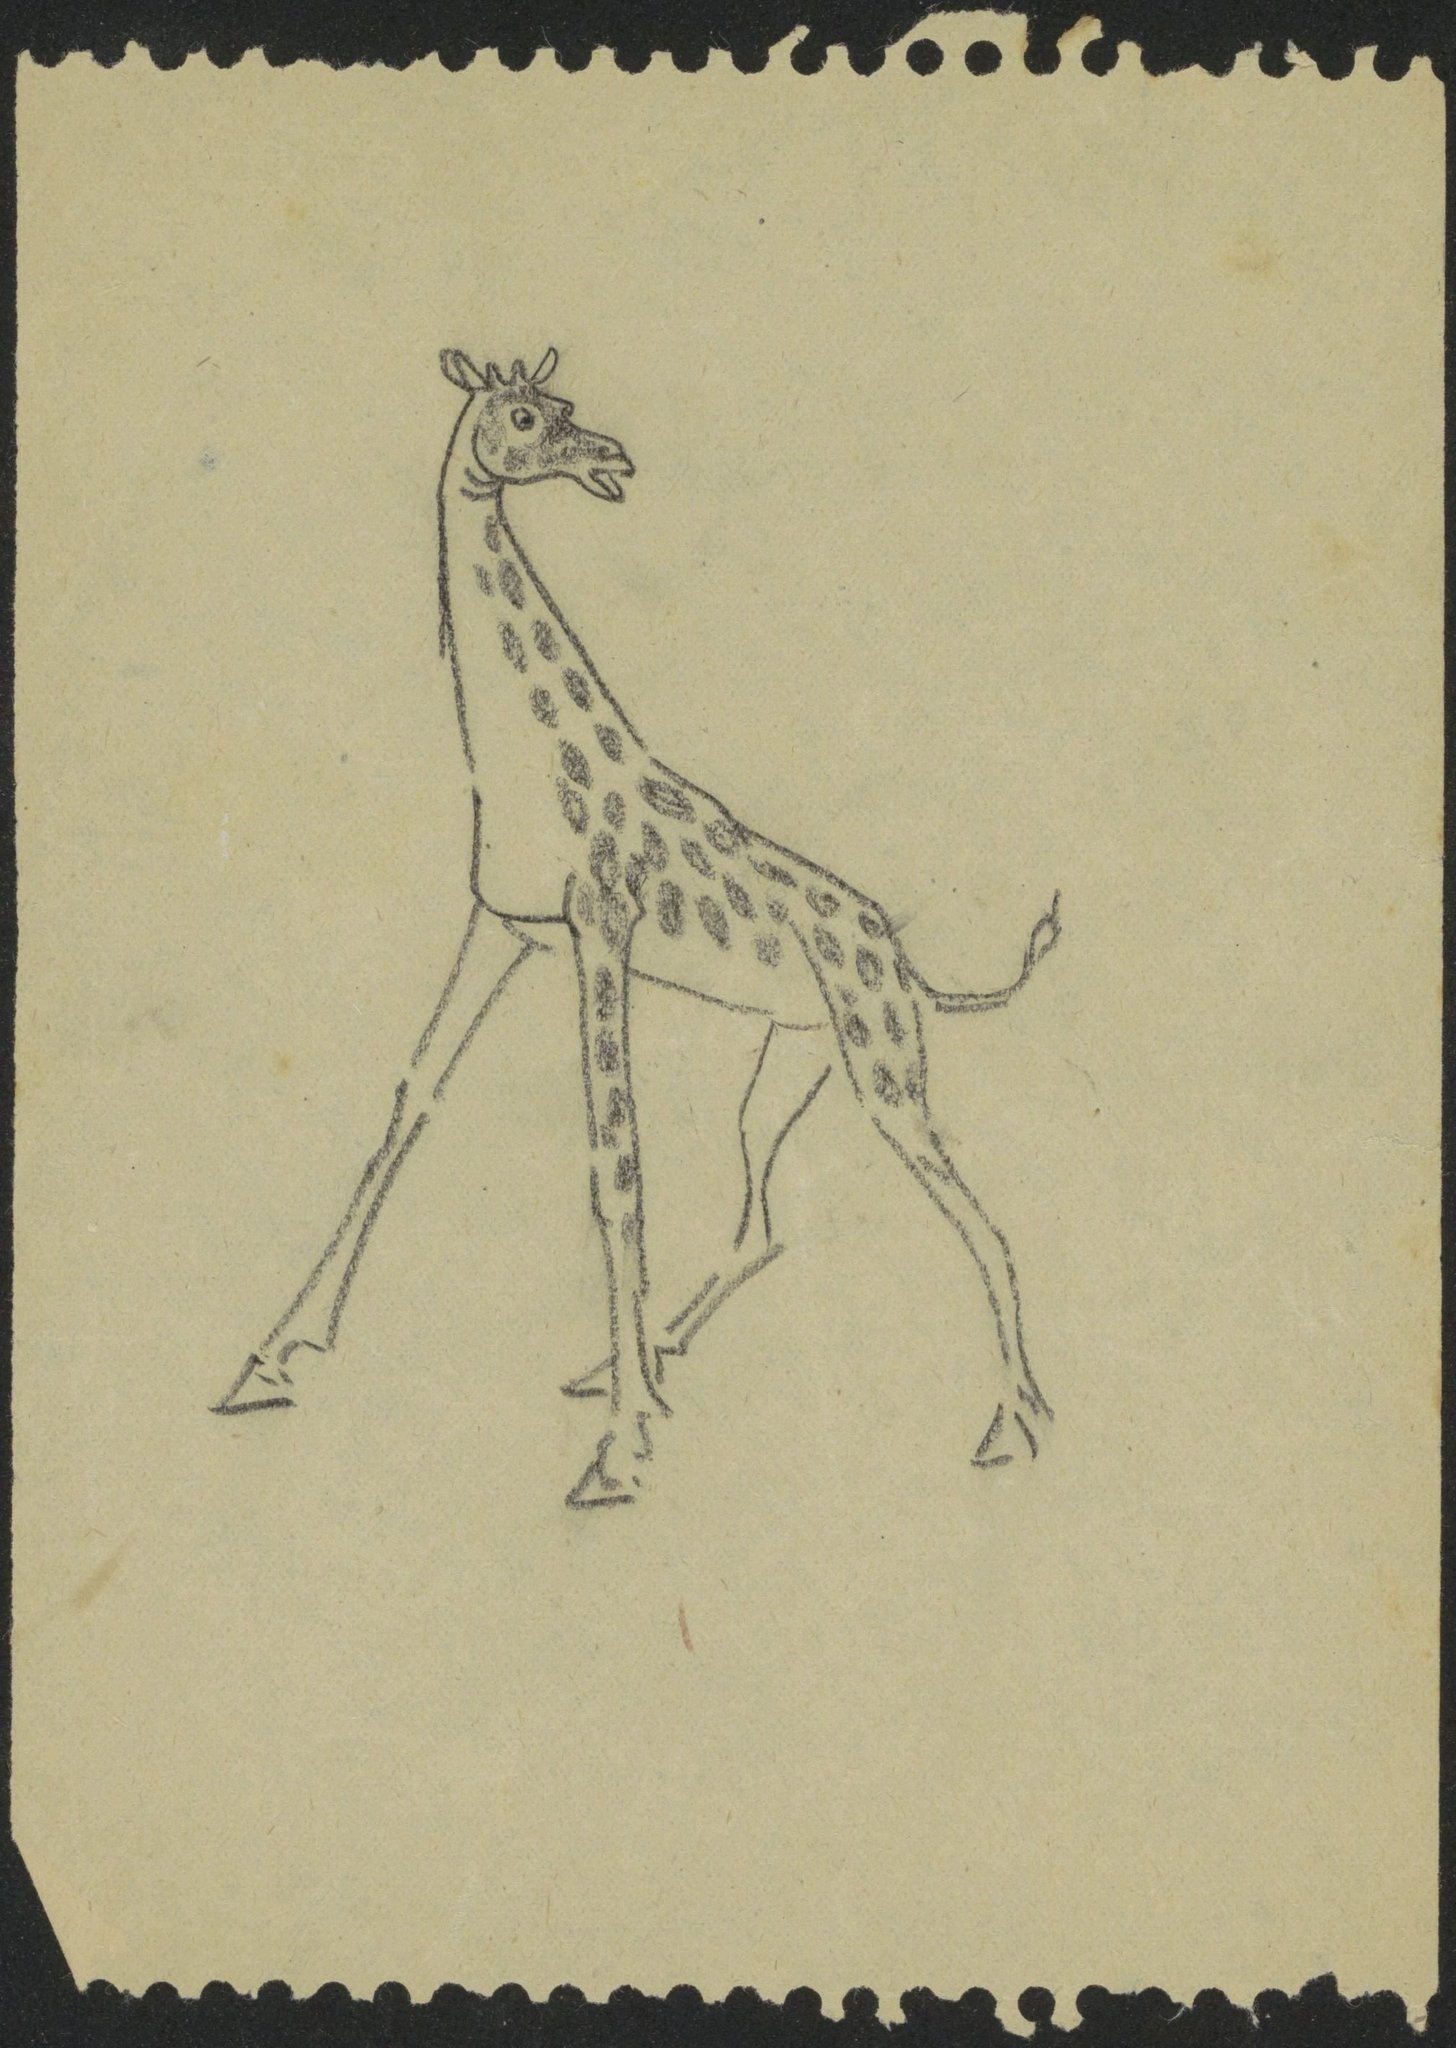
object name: drawing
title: Giraffe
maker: gerrit willem dijsselhof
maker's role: designer, draughtsman, print maker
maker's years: 1866-1924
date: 1904-1906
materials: chalk, paper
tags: hoofed animals: giraffe